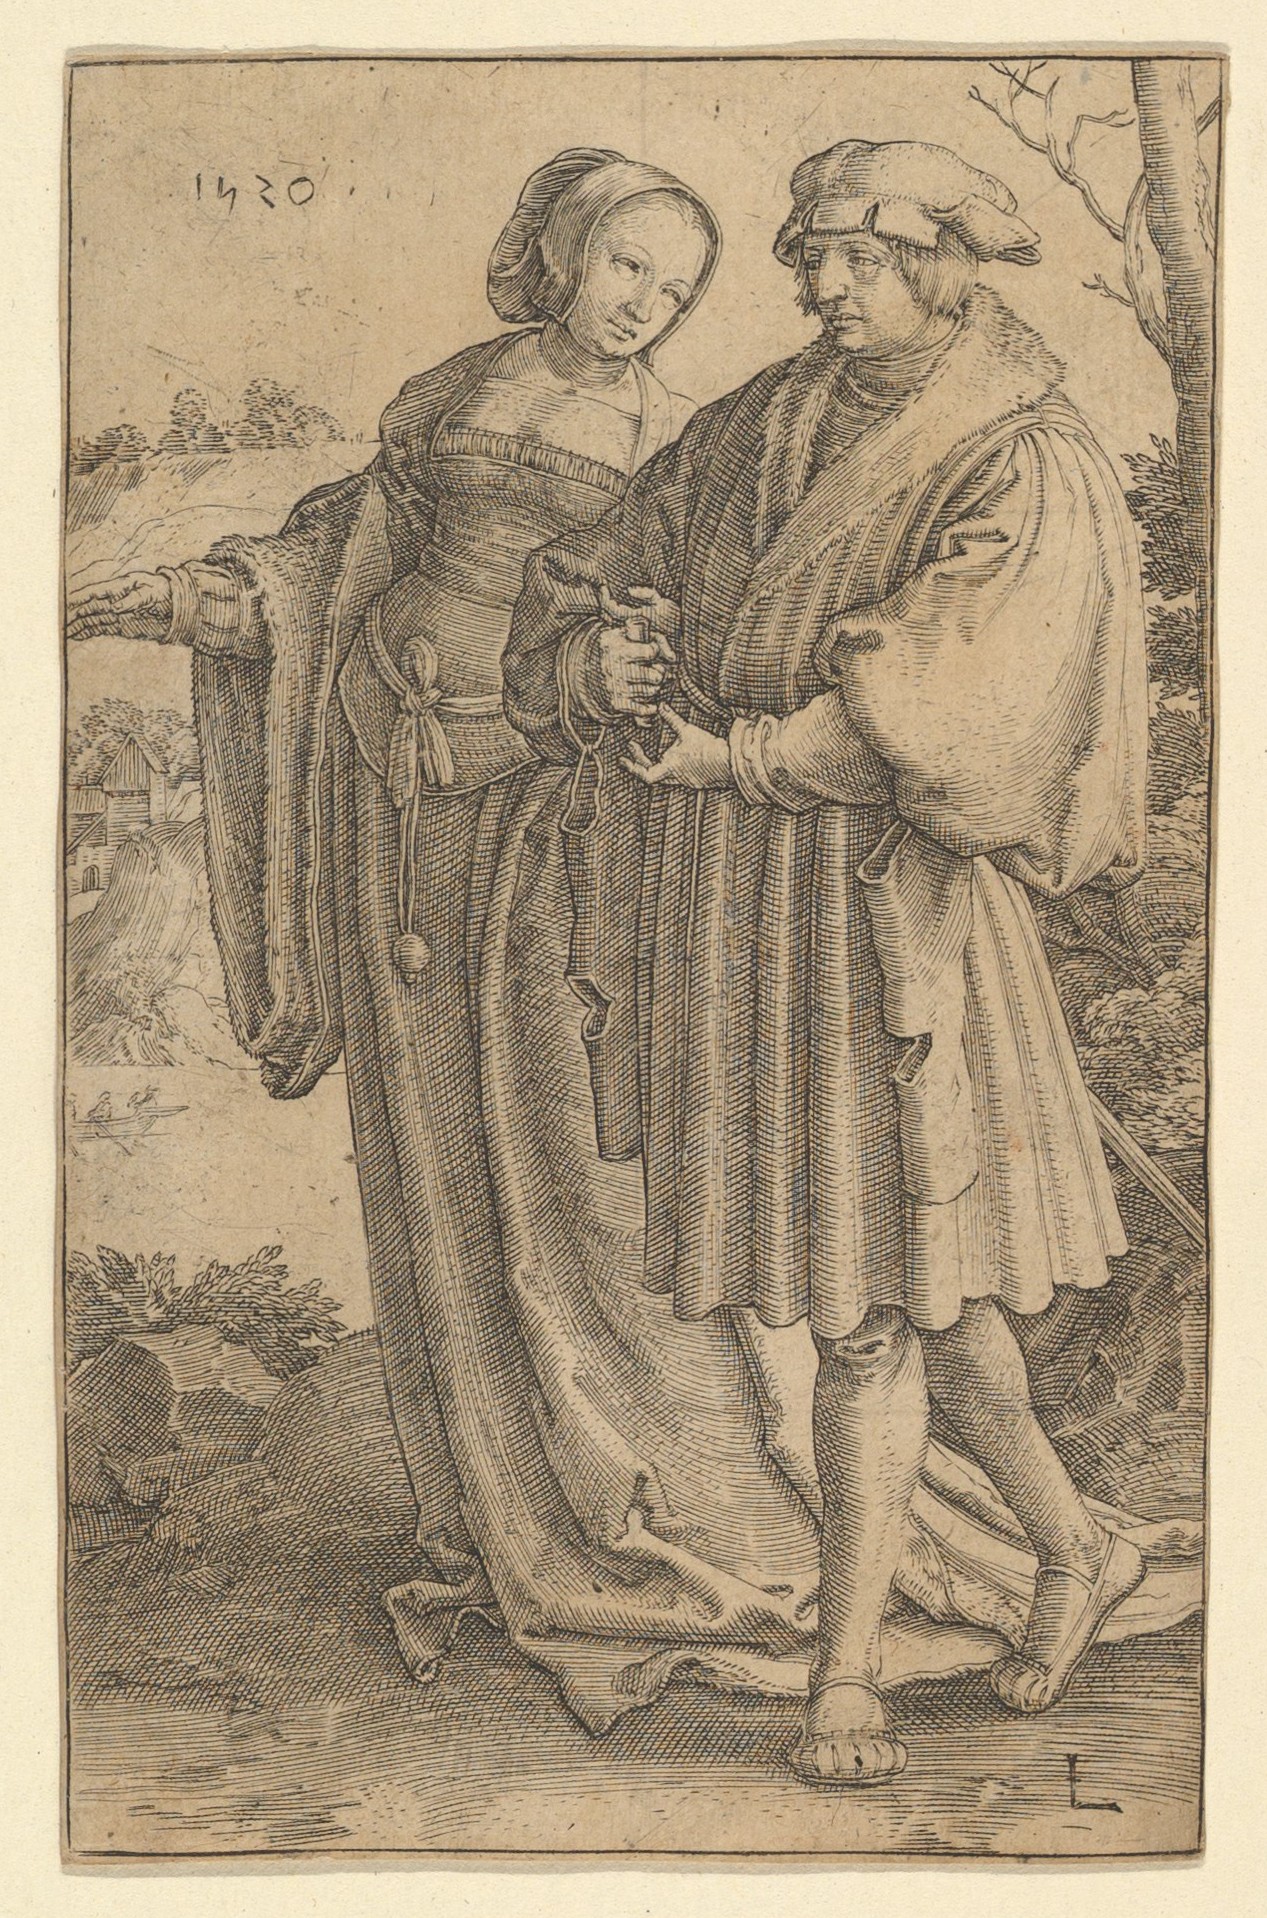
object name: print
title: The Promenade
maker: lucas van leyden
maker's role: artist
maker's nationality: netherlandish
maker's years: 1494-1533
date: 1520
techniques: engraving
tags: men,women,walking